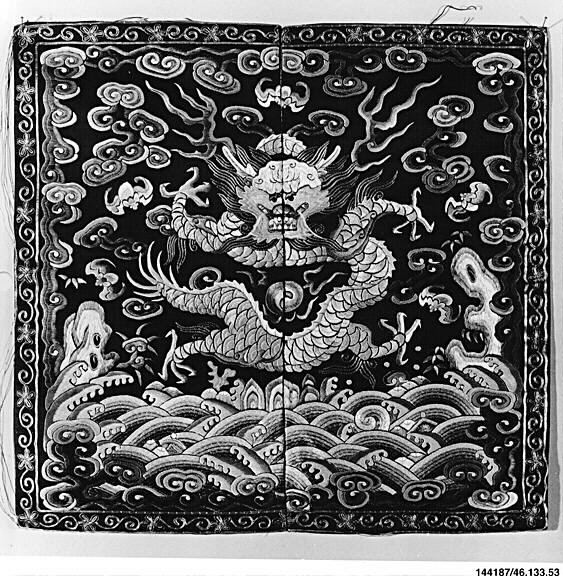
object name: rank badge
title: Rank Badge with Four-Clawed Dragon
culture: chinese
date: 1734-1766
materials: metal thread, silk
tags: bats,dragons